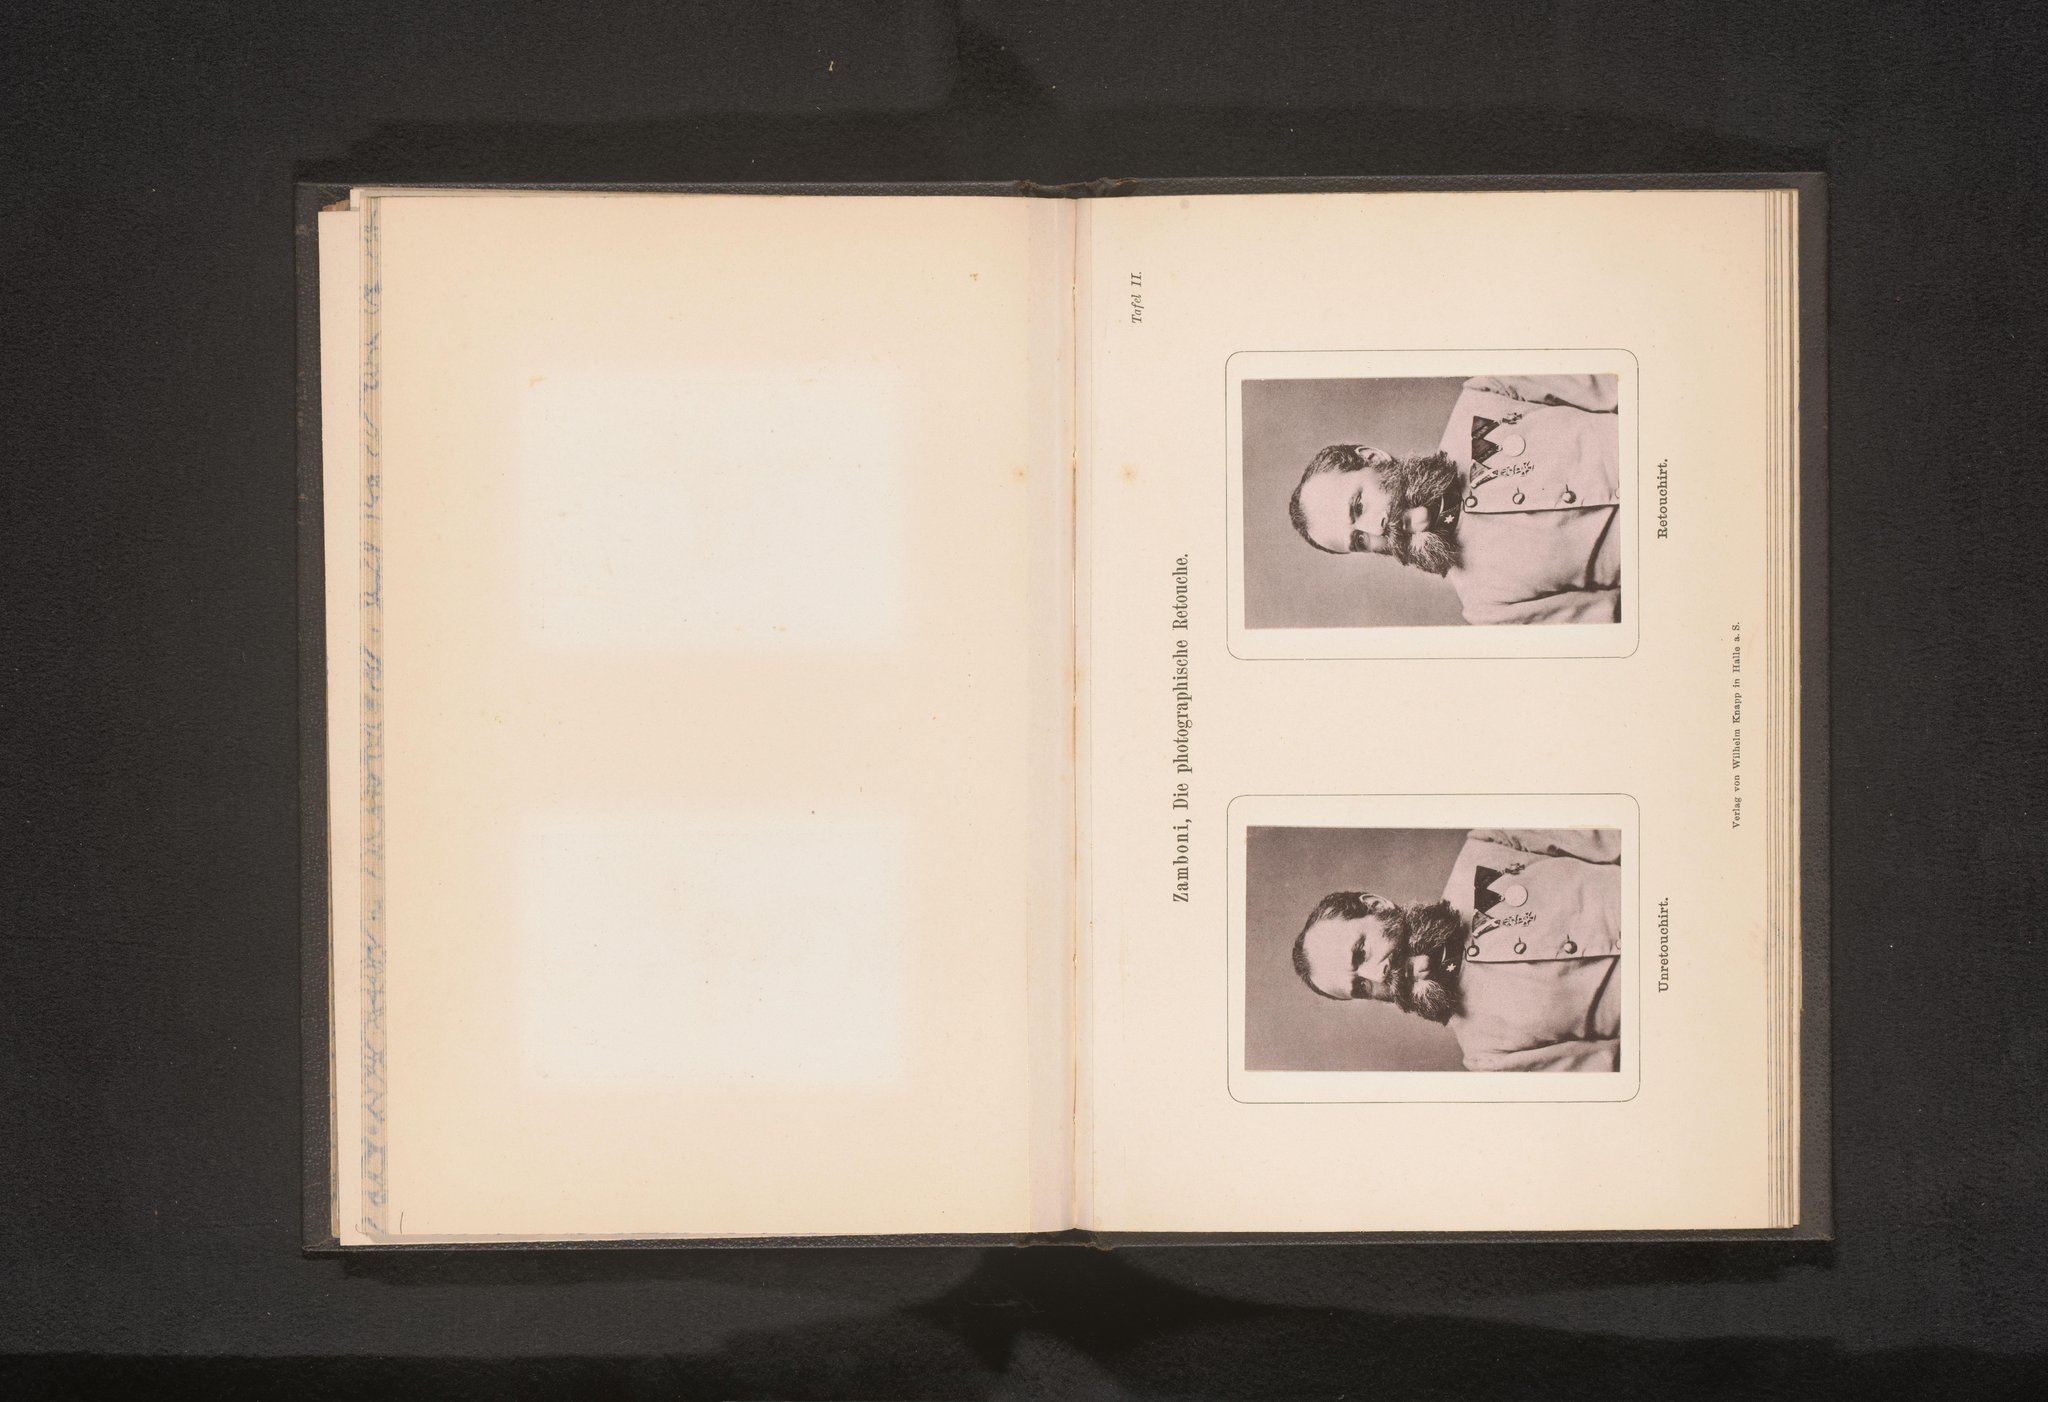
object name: page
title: Twee portretten van een onbekende man met militaire onderscheidingen, met en zonder retouche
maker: Anonymous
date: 1878-1888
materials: paper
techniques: photograph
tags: old man, decorations, honours (as symbols of the state, etc.)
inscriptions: inscription: ‘Unretouchirt. Retouchirt.’, number: ‘Tafel II.’